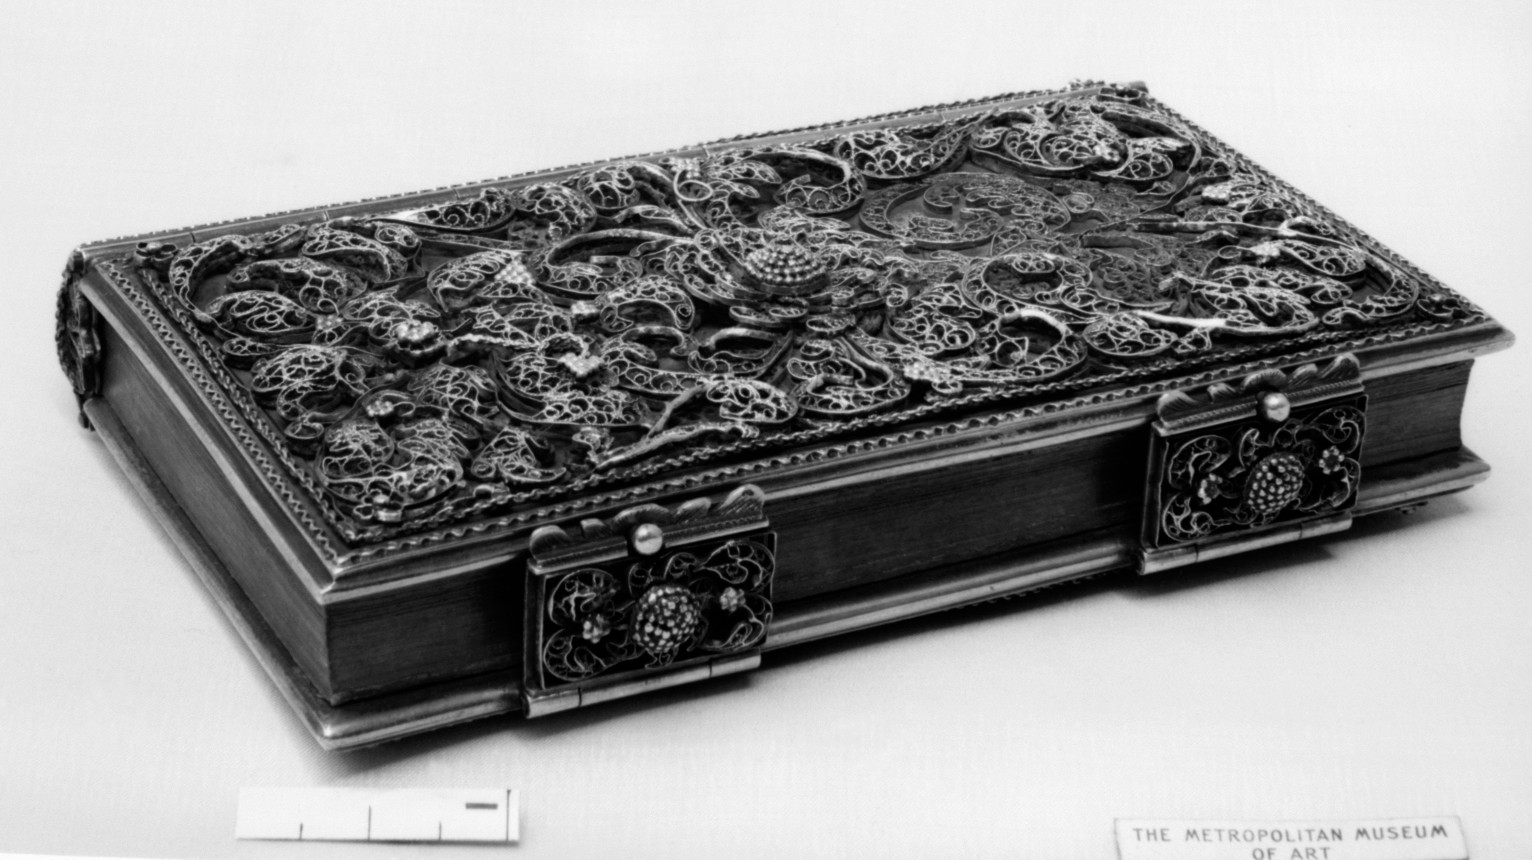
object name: book cover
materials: silver, silver gilt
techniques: filigree